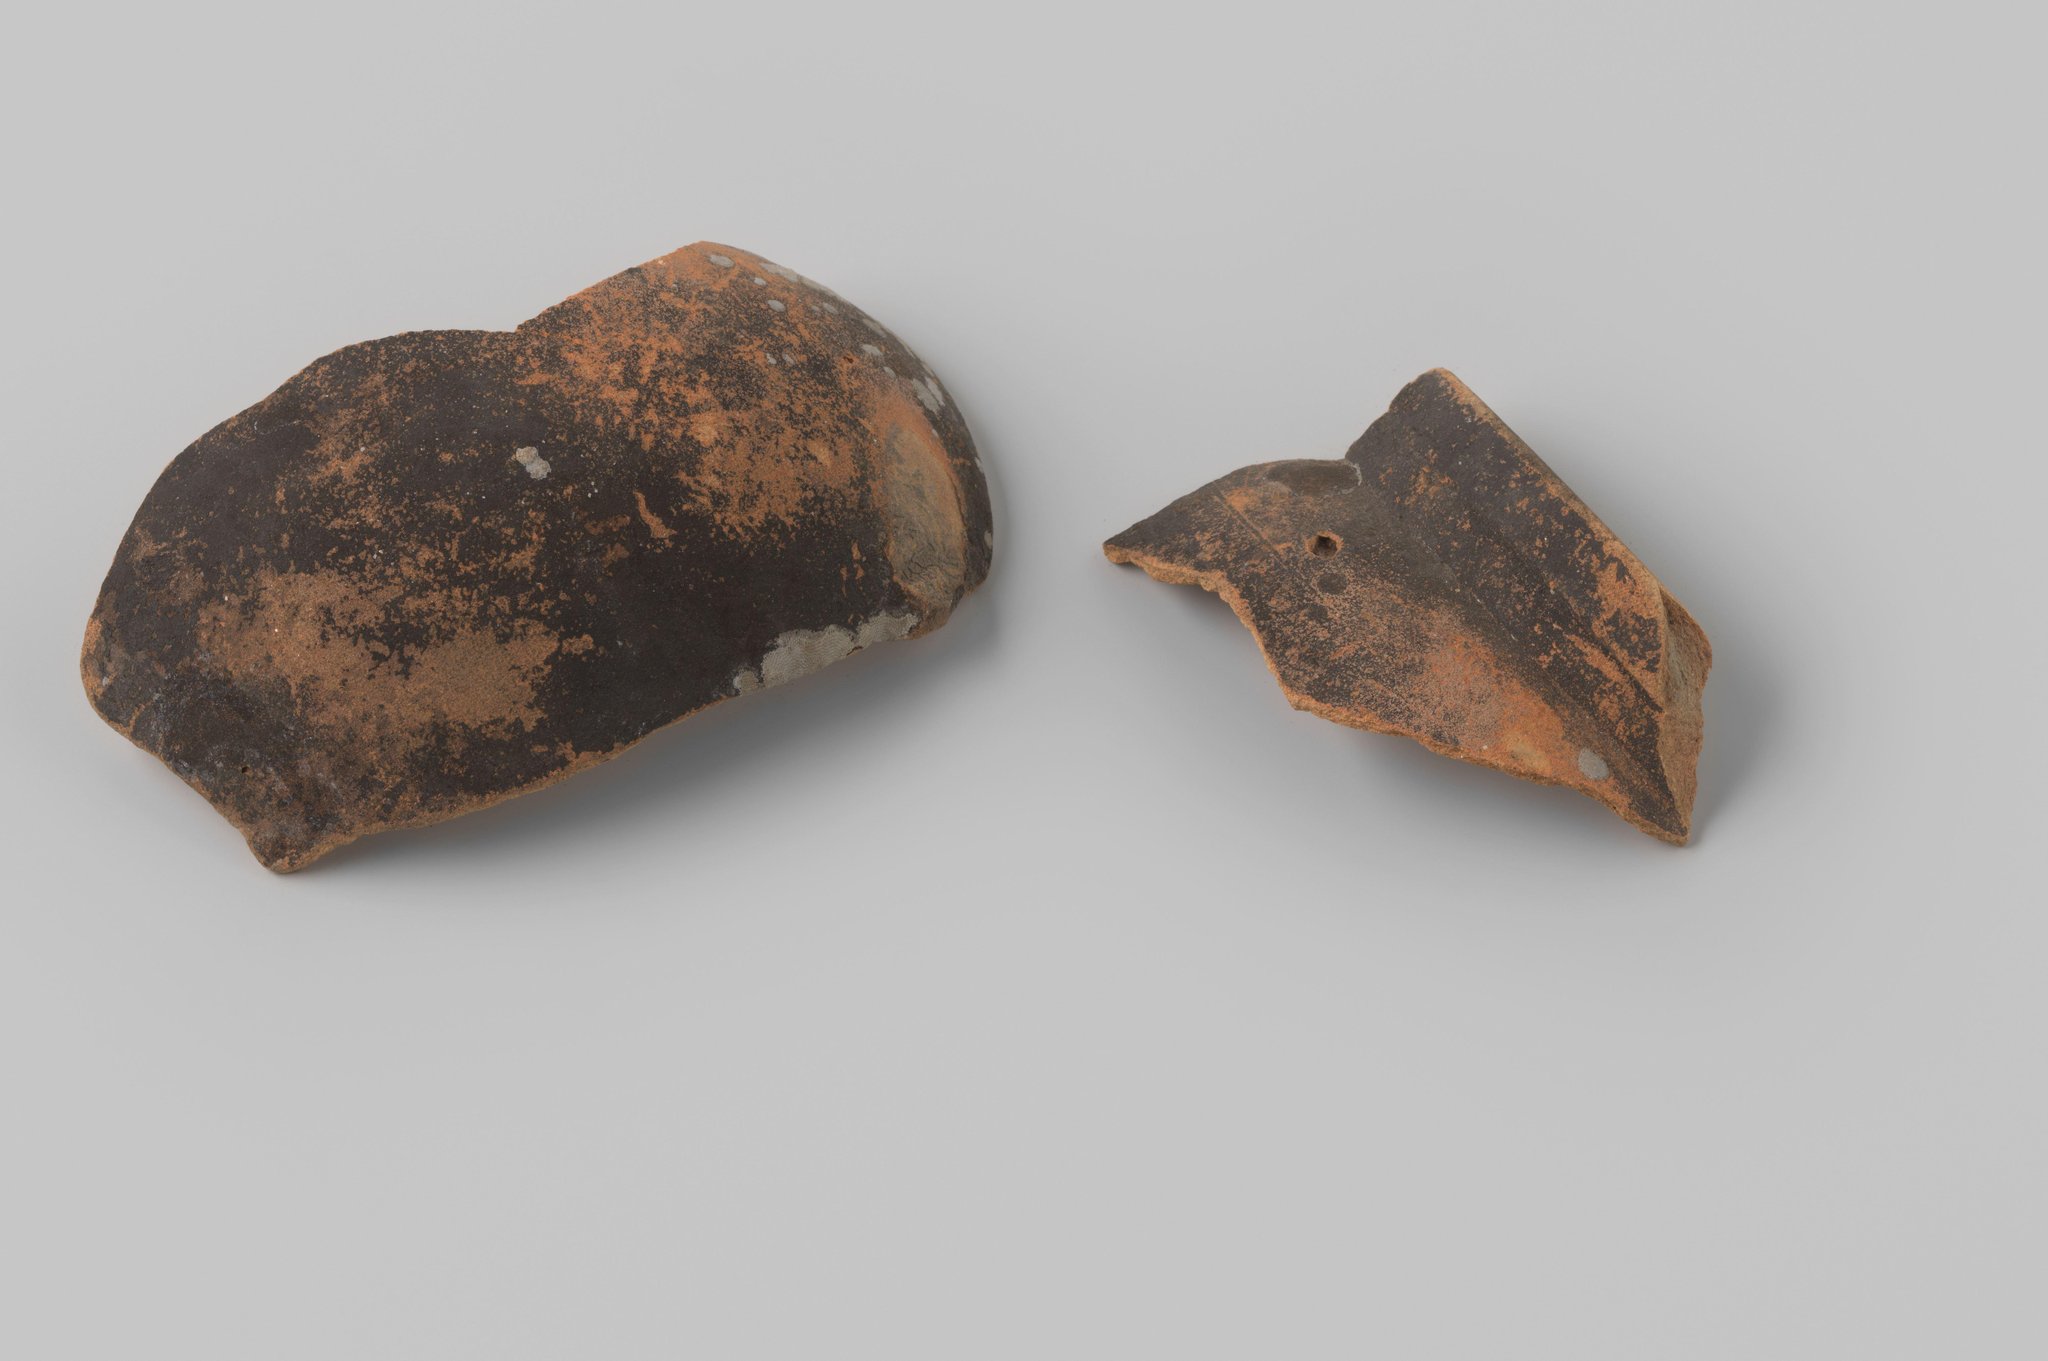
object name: sherd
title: Scherven van roodbakkend aardewerk uit V.O.C.-schip de 'Witte Leeuw'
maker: Anonymous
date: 1613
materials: earthenware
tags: verenigde oostindische compagnie, sint-helena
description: Scherven van roodbakkend aardewerk uit V.O.C.-schip de 'Witte Leeuw'